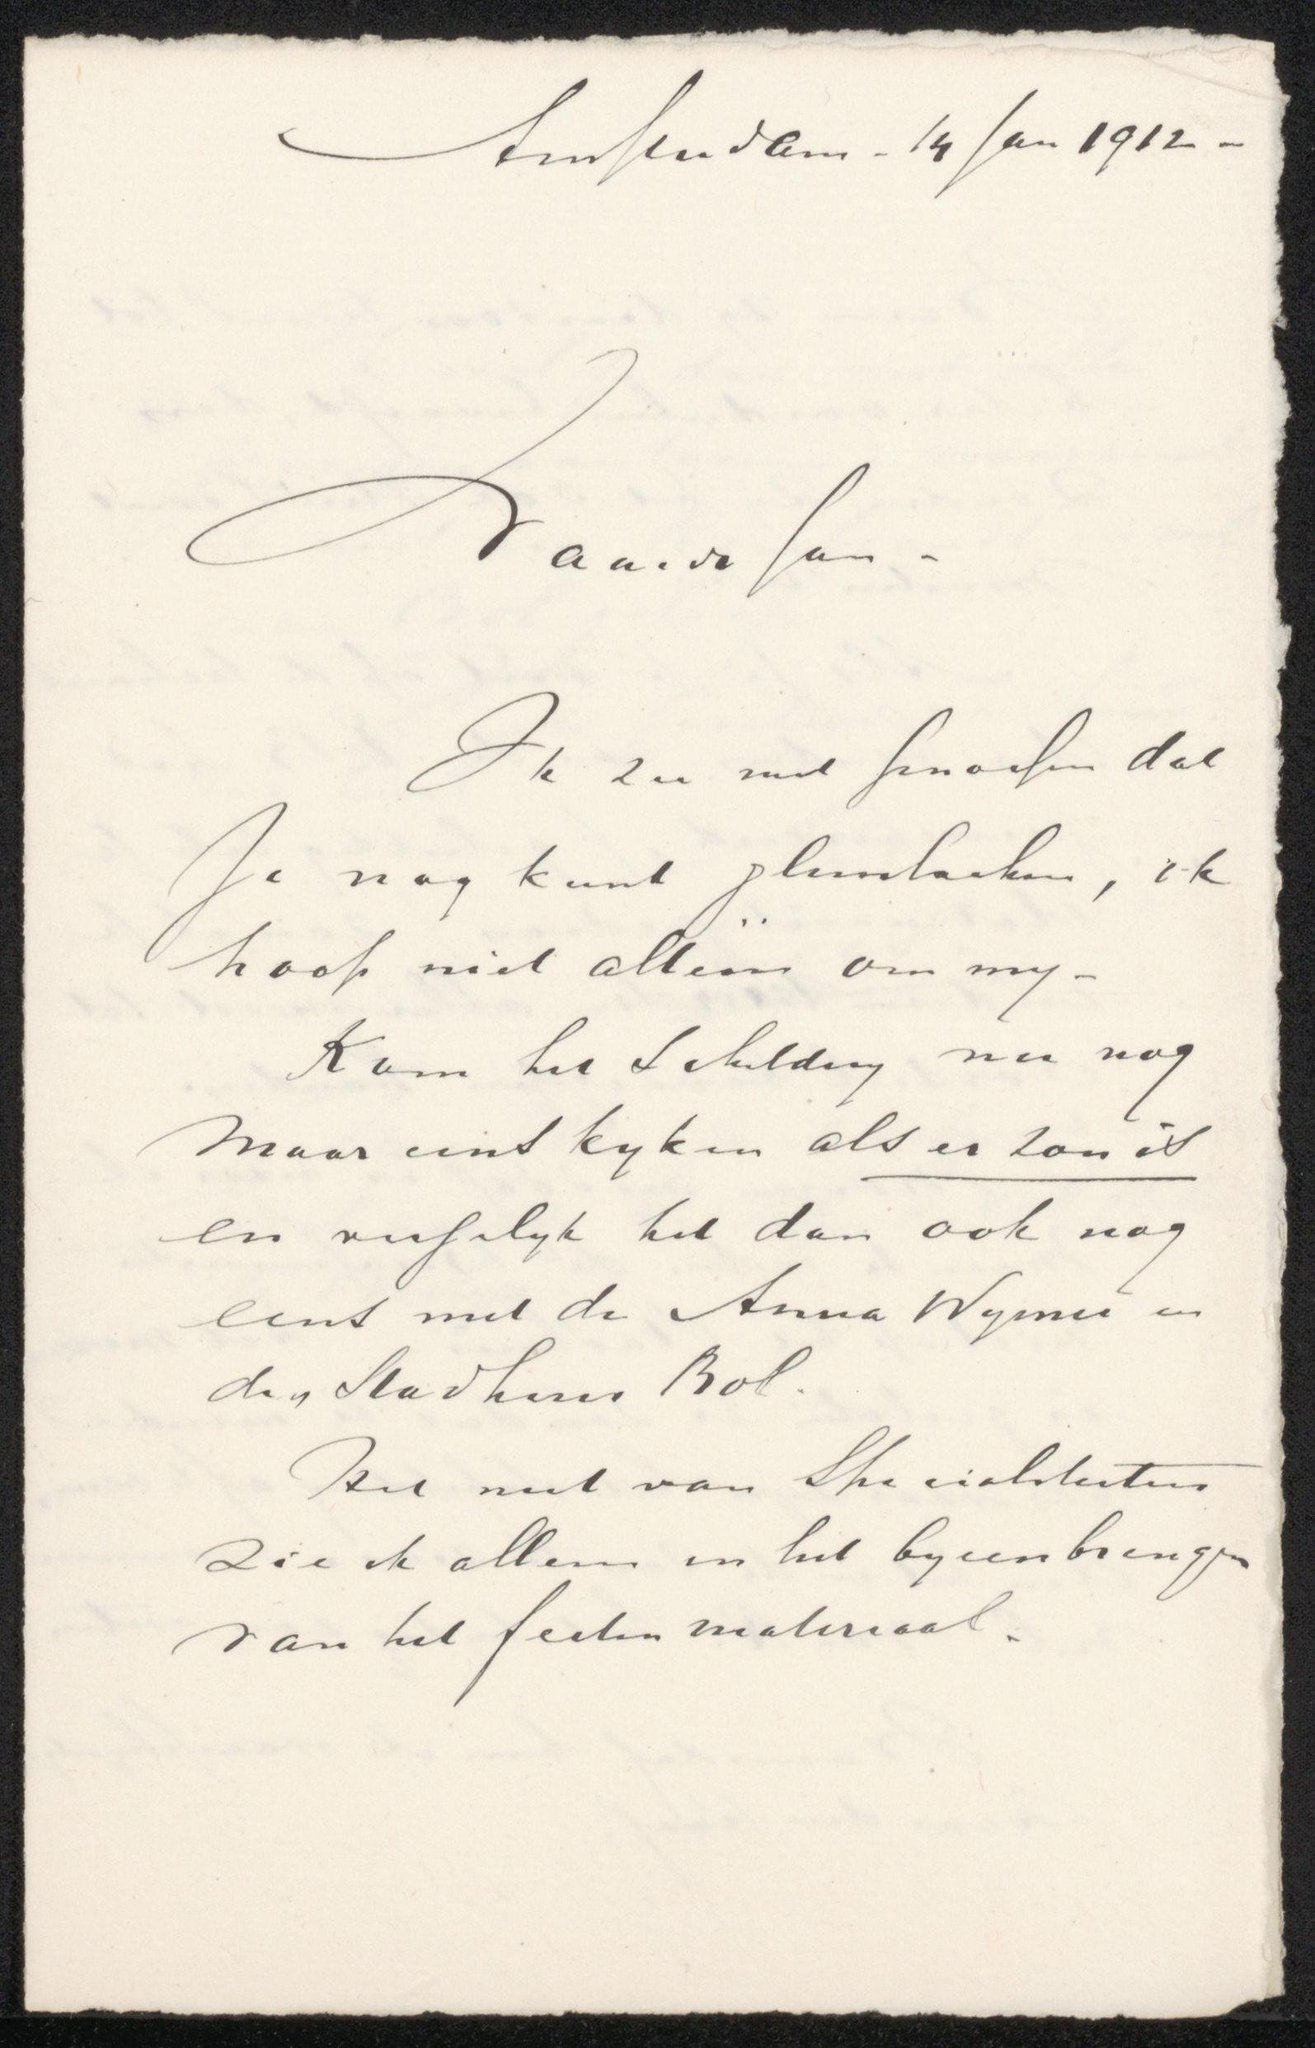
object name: letter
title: Brief aan Jan Veth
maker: cornelis gerardus t hooft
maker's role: draughtsman, painter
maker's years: 1866-1936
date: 1912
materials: ink, paper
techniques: pen, writing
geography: amsterdam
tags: ferdinand bol, designer, jan veth, leiden, rembrandt van rijn, painting (including book-illumination, miniature-painting), berlin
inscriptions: collector's mark: ‘RPK’, watermark